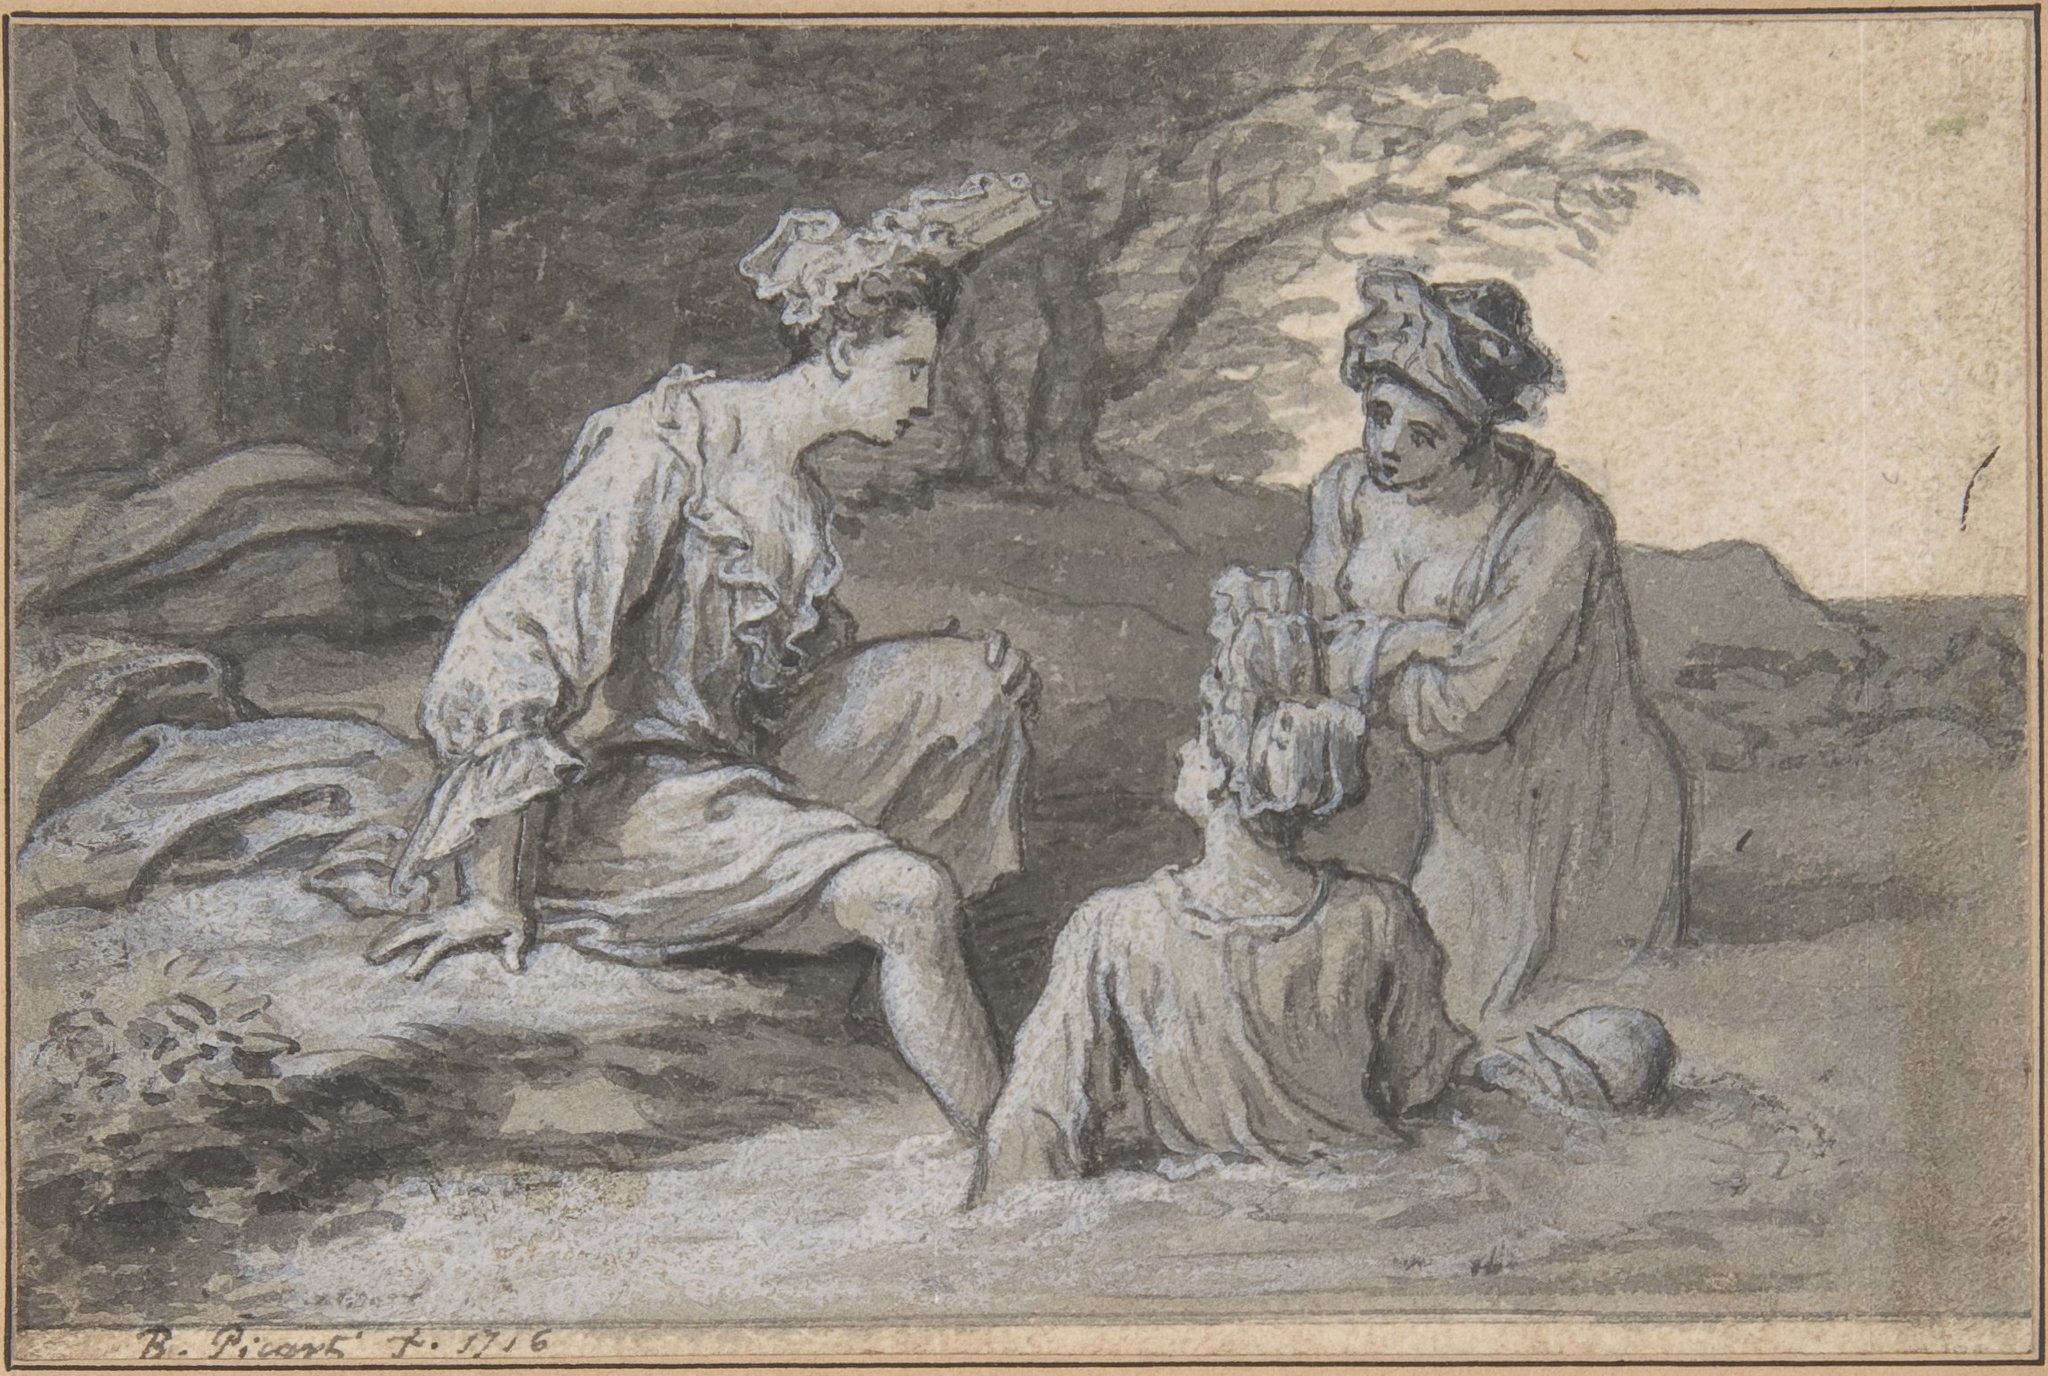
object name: drawing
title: Ladies Bathing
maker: claude simpol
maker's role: artist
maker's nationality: french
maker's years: 1666-1716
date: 1717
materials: graphite, ink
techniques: brush, heightening, incising, pen, wash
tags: women,trees,bathing